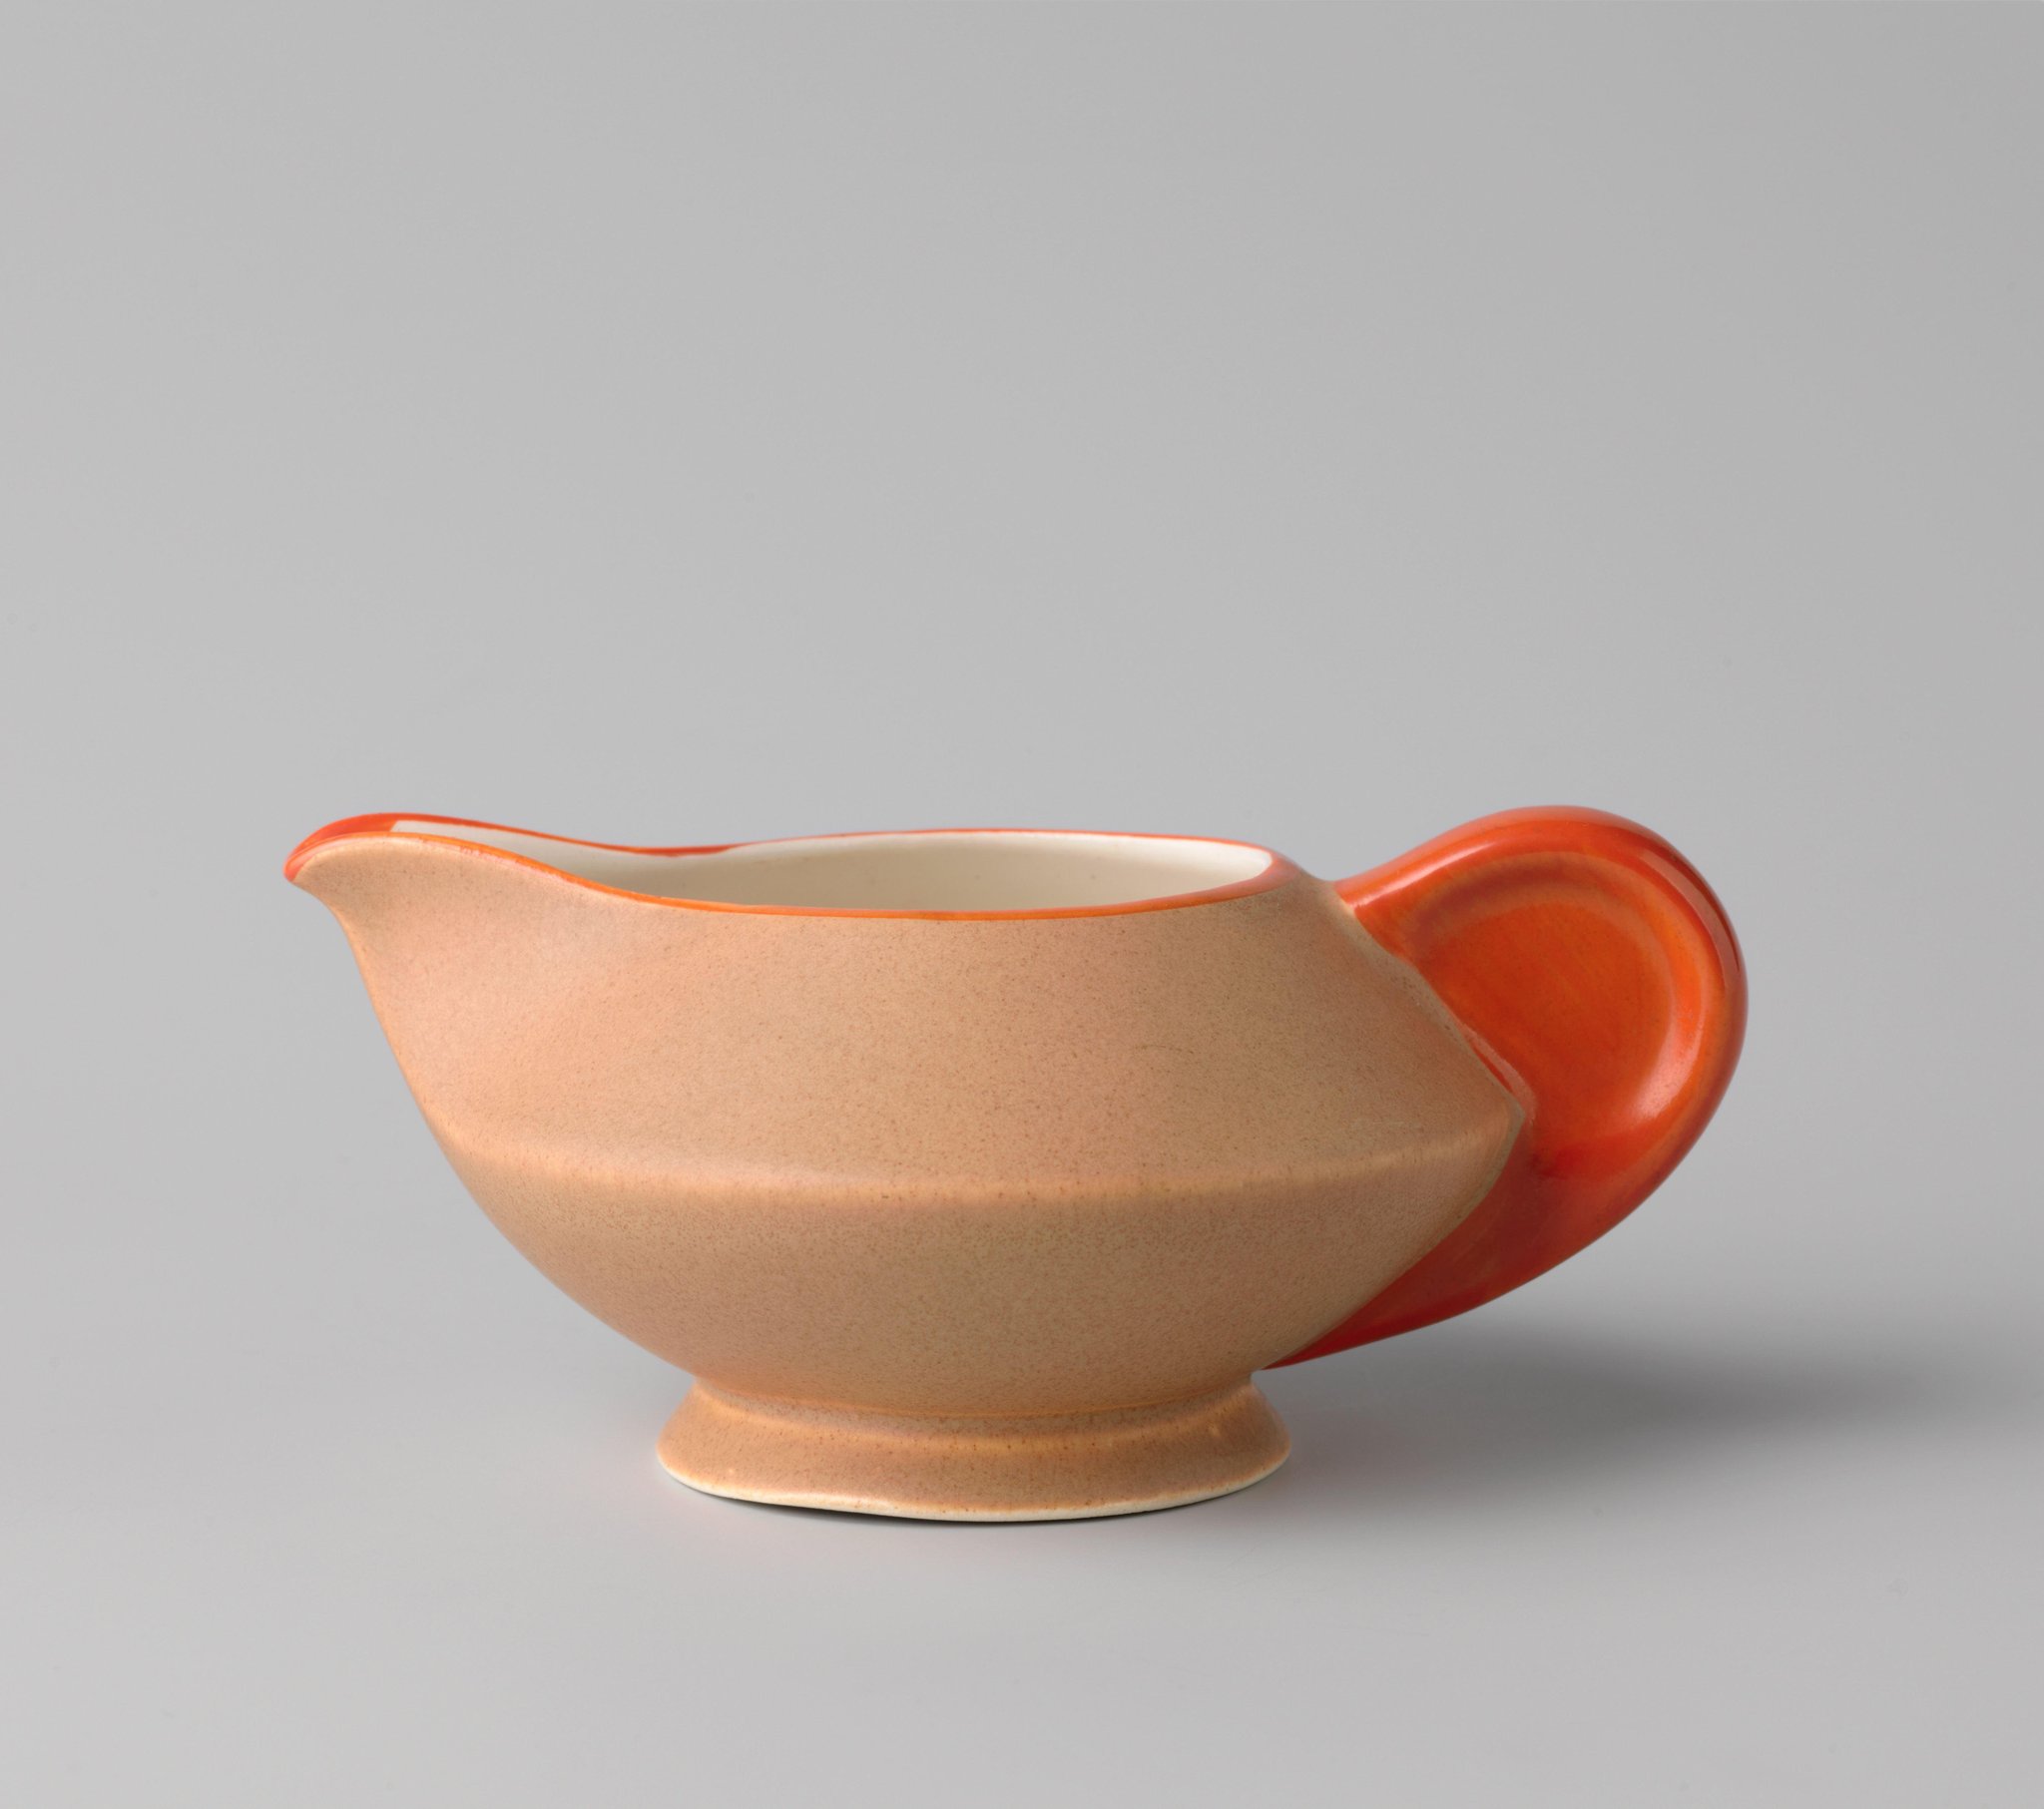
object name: milk jug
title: Melkkan, deel van een theeservies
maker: edmond bellefroid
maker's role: ceramicist, painter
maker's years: 1893-1971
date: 1934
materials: earthenware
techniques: painted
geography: maastricht